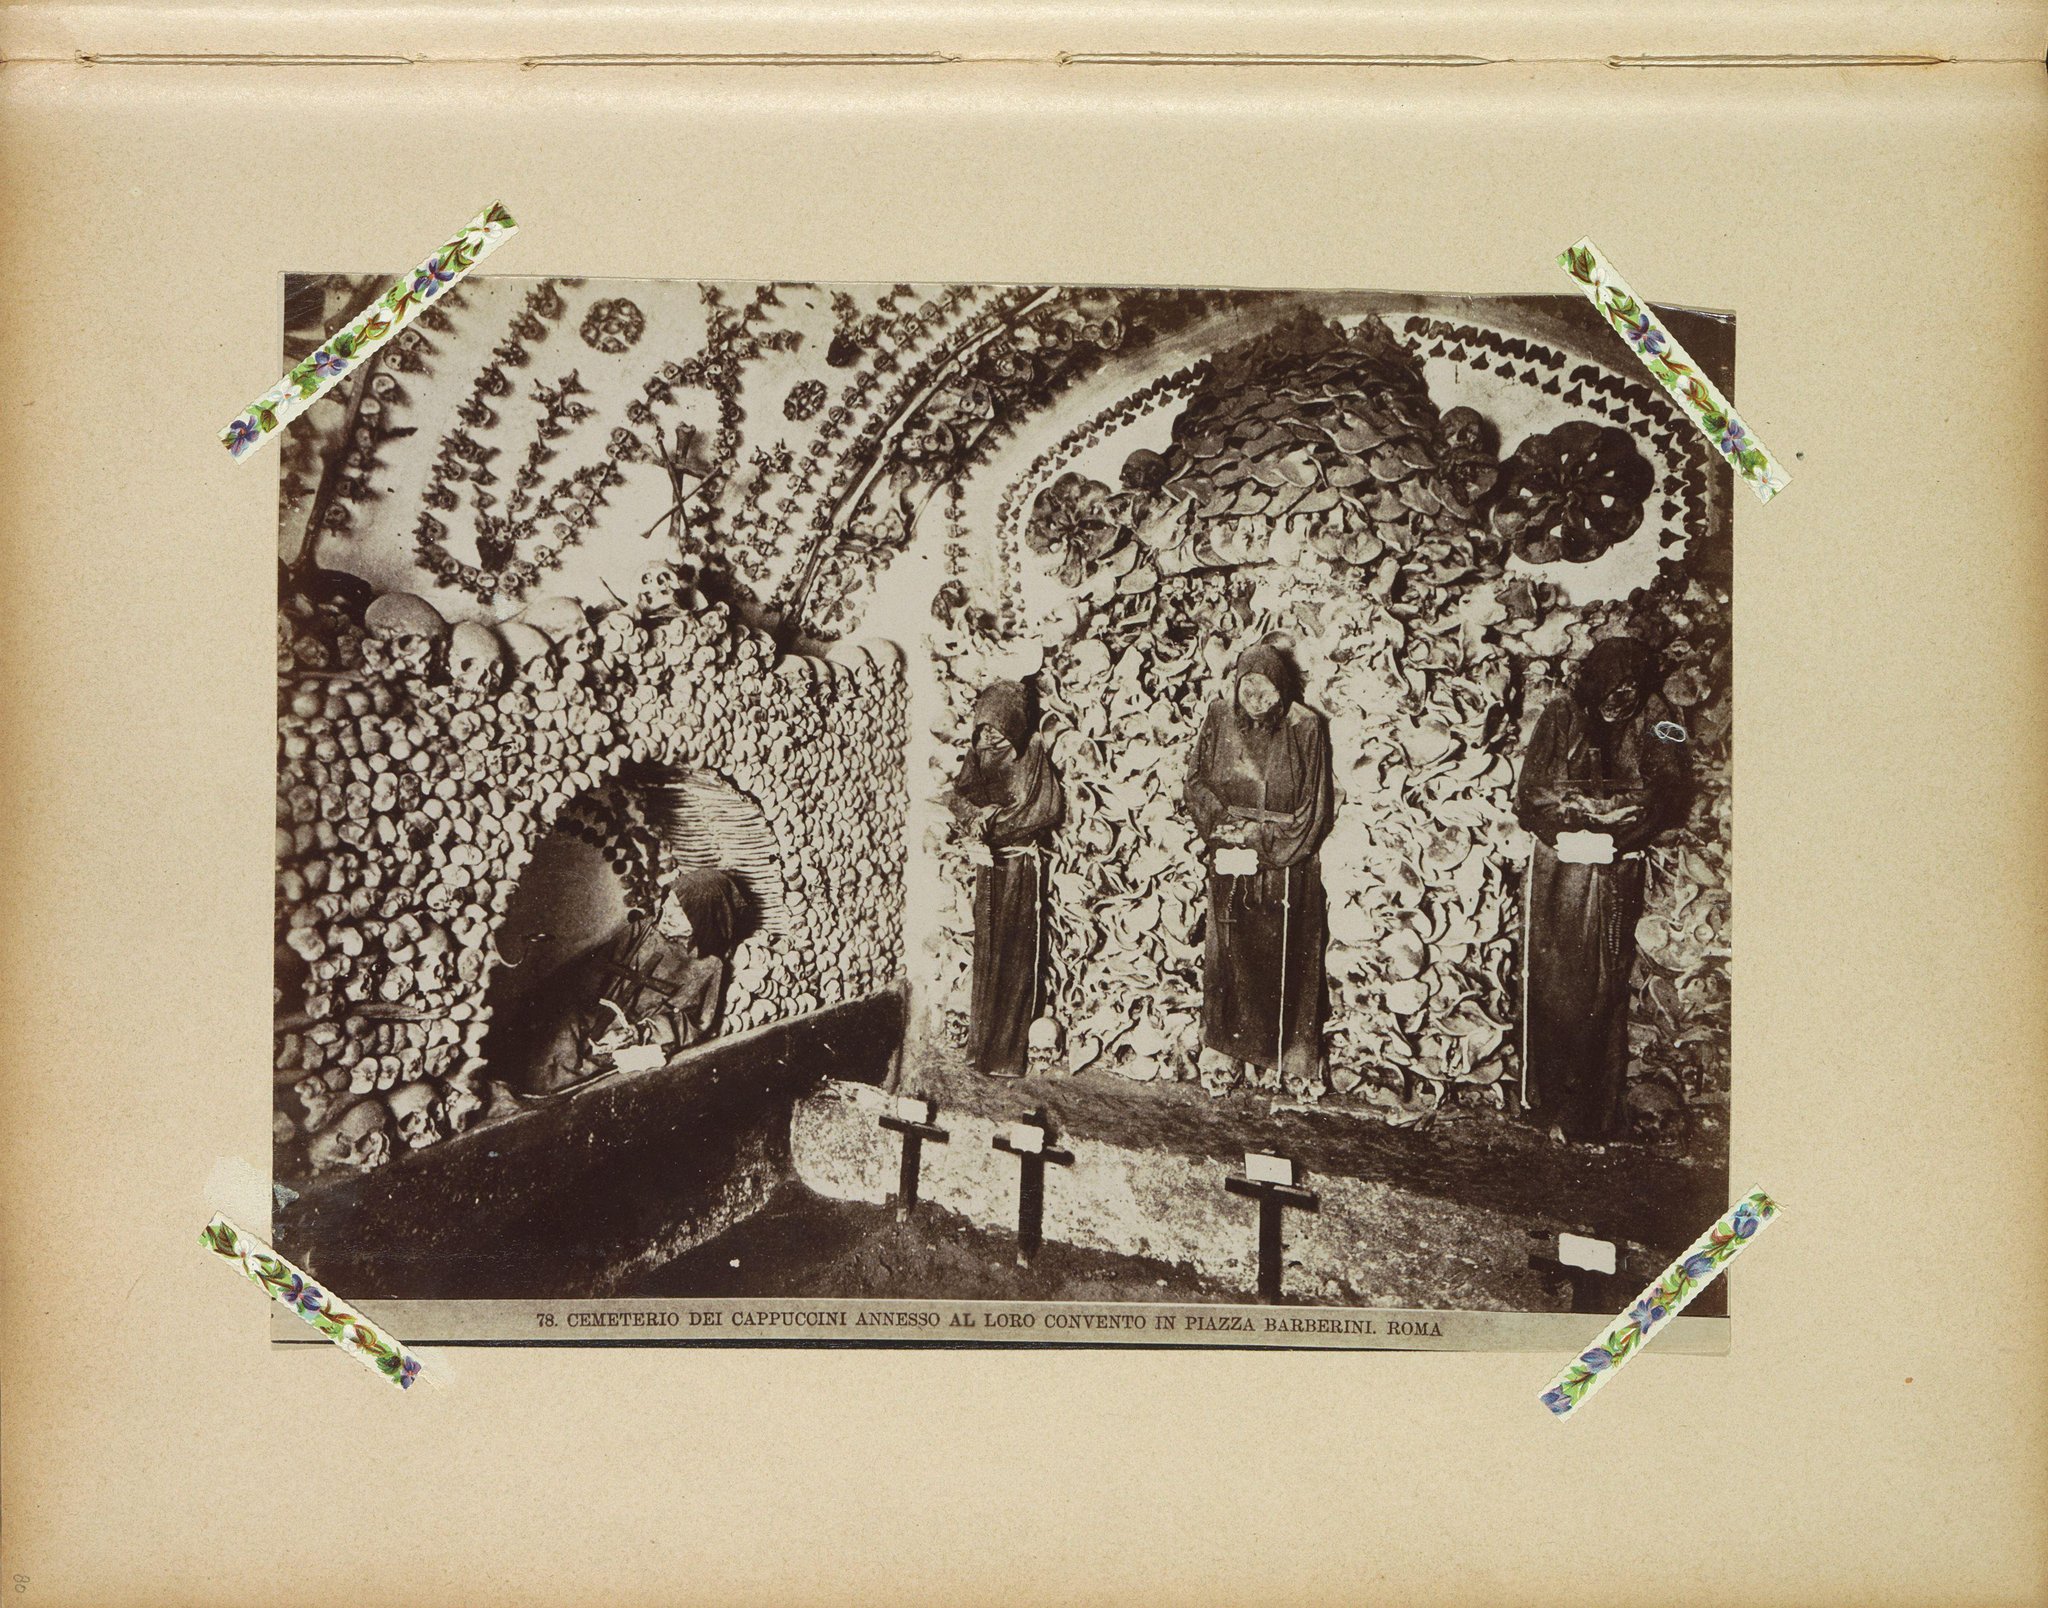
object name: photograph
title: Knekelhuis (ossuarium) van het Kapucijnenklooster in Rome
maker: Anonymous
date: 1860-1900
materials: photographic support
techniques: albumen print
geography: rome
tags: charnelhouse, ossuary, rome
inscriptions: number: ‘78’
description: Onderdeel van Fotoalbum met opnames van bezienswaardigheden in Italiaanse steden en van kunstwerken.